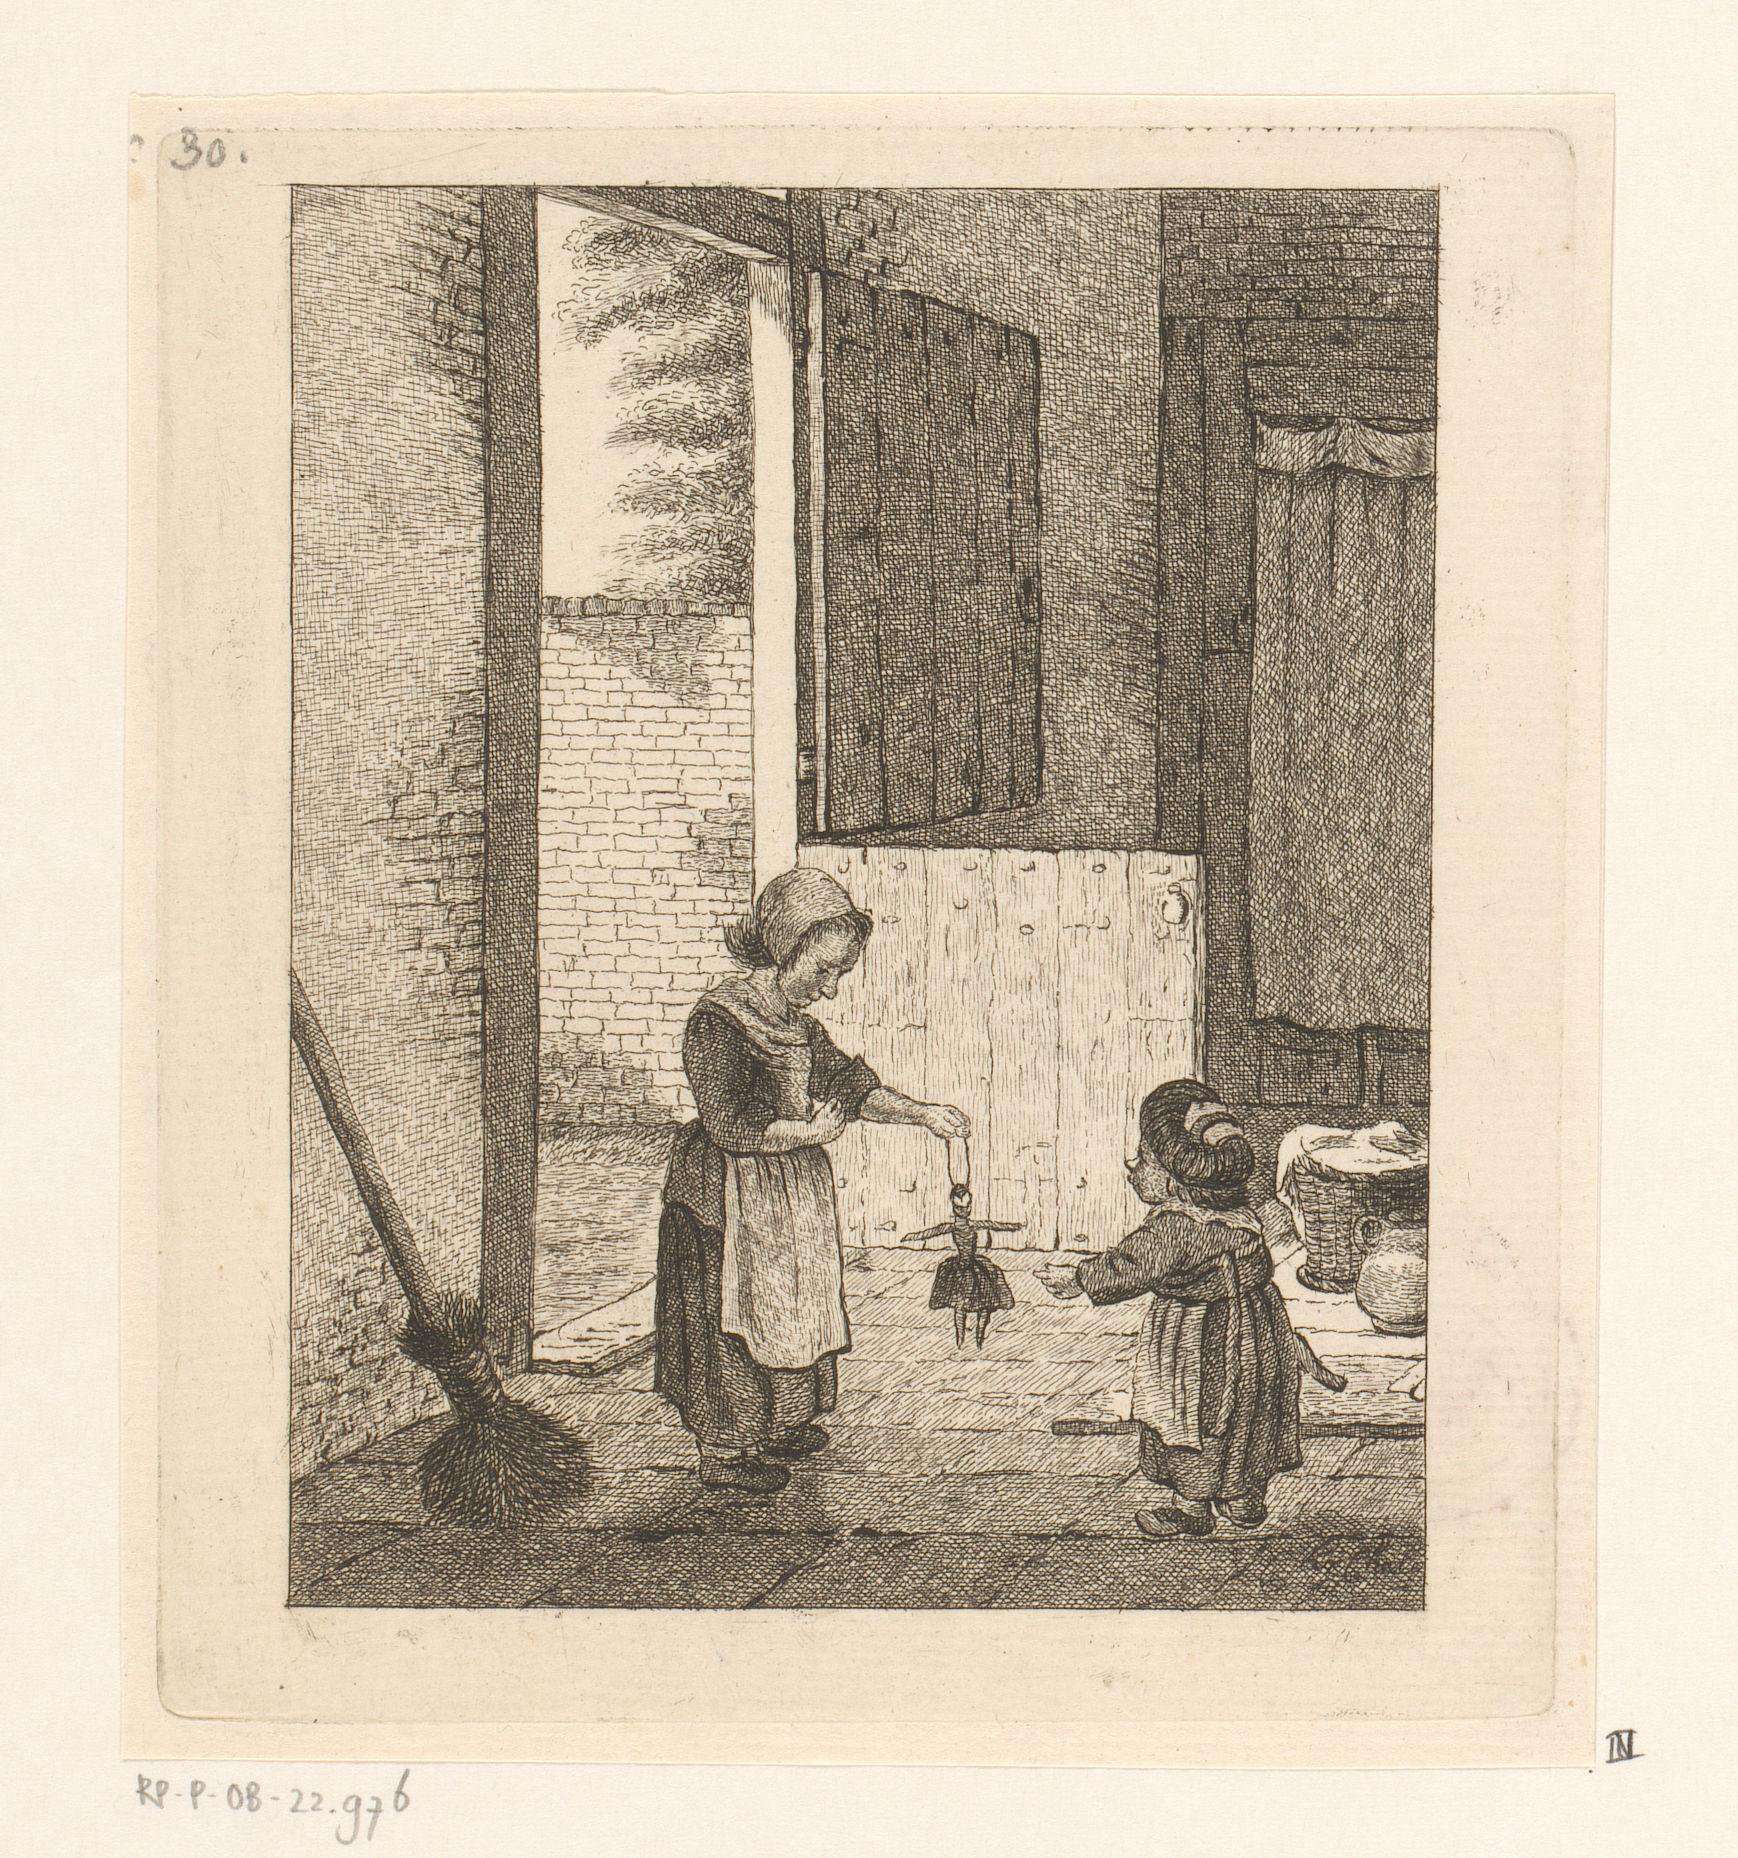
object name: print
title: Twee meisjes spelend met een pop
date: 1779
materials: paper, pencil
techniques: etching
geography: leiden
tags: (playing with) dolls, child (at home) - aa - girl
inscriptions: collector's mark: Lugt 240